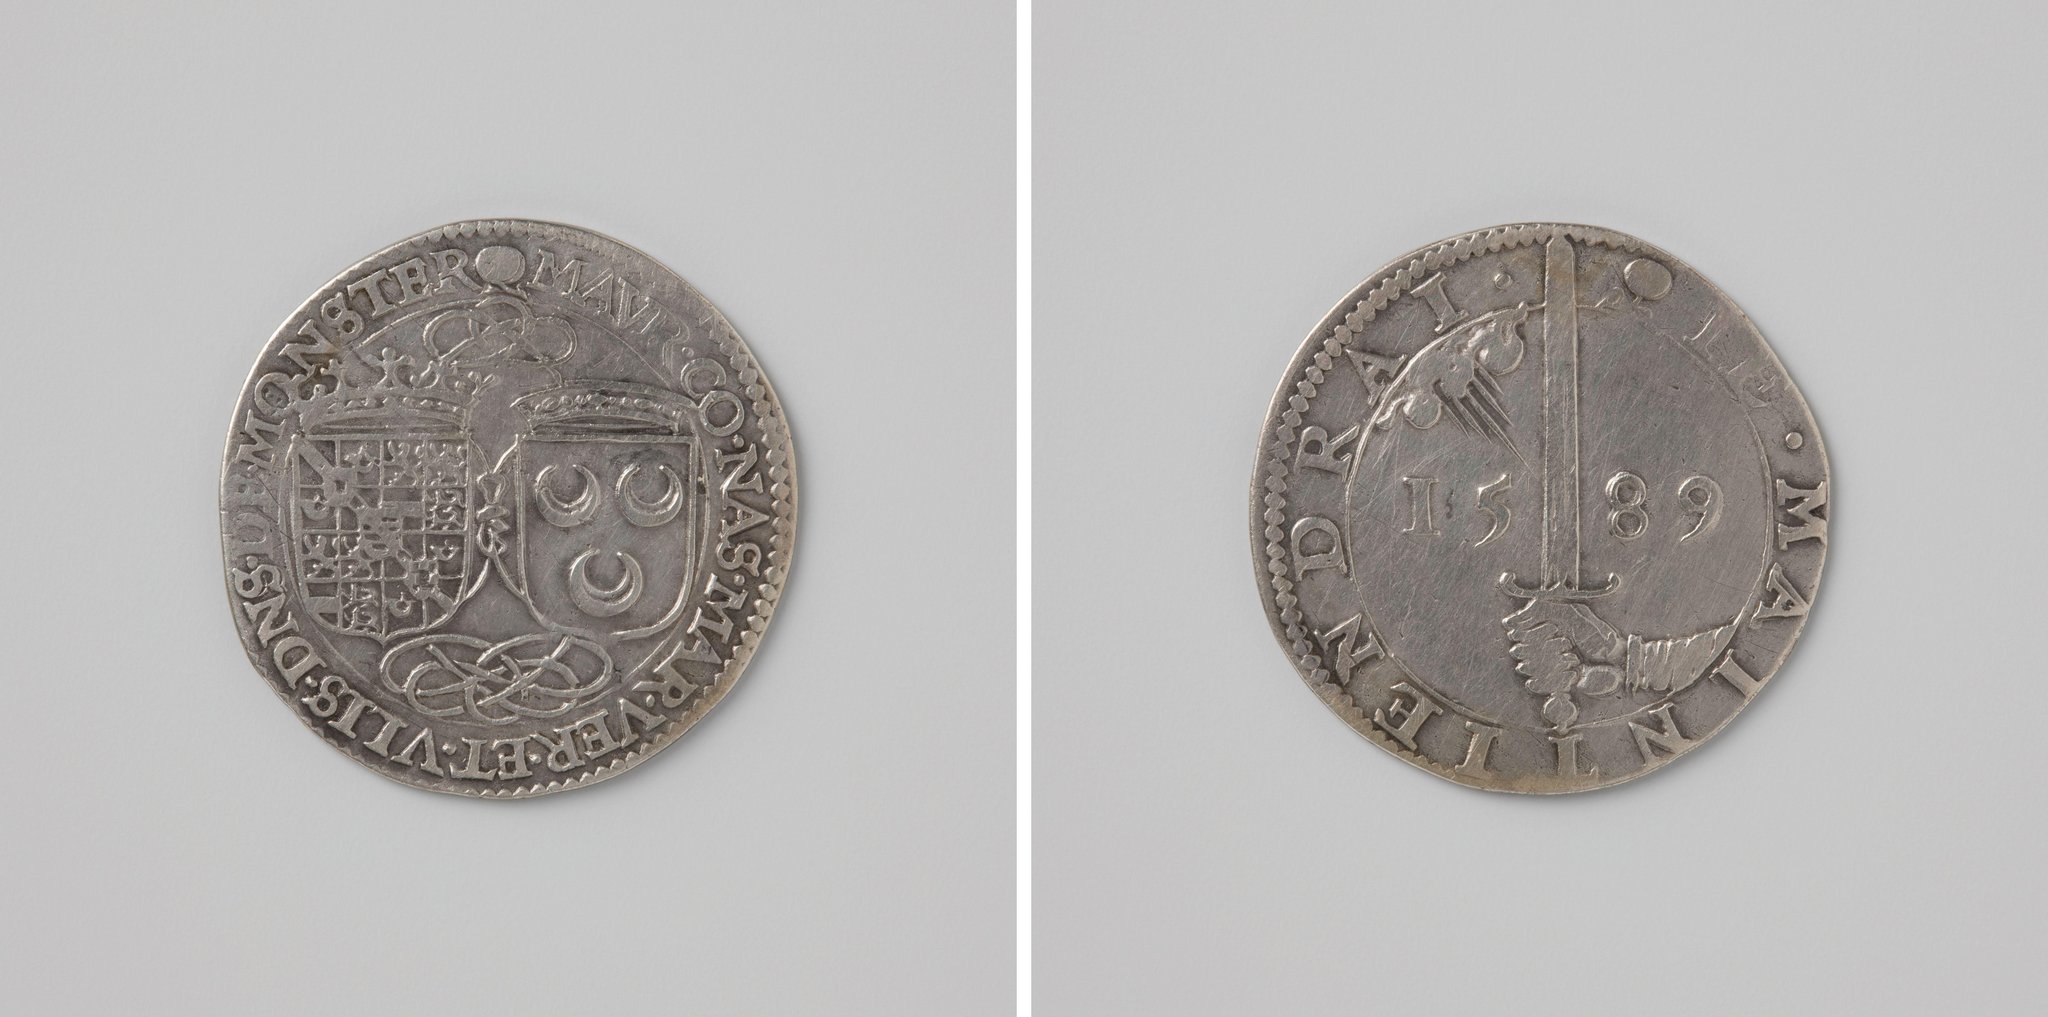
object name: strooipenning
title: Maurits van Oranje ingehuldigd als heer van Monster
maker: Anonymous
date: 1589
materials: silver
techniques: striking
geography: netherlands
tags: maurice (prince of orange)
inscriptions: circumscription: ‘MAVR CO NAS MAR VER ET VLIS DNS DE MONSTER’, circumscription: ‘IE MAINTIENDRAI / 1589’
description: Zilveren penning. Voorzijde: twee door linten met elkaar verbonden gekroonde wapenschilden binnen omschrift. Keerzijde: hand met zwaard tussen jaartal binnen omschrift